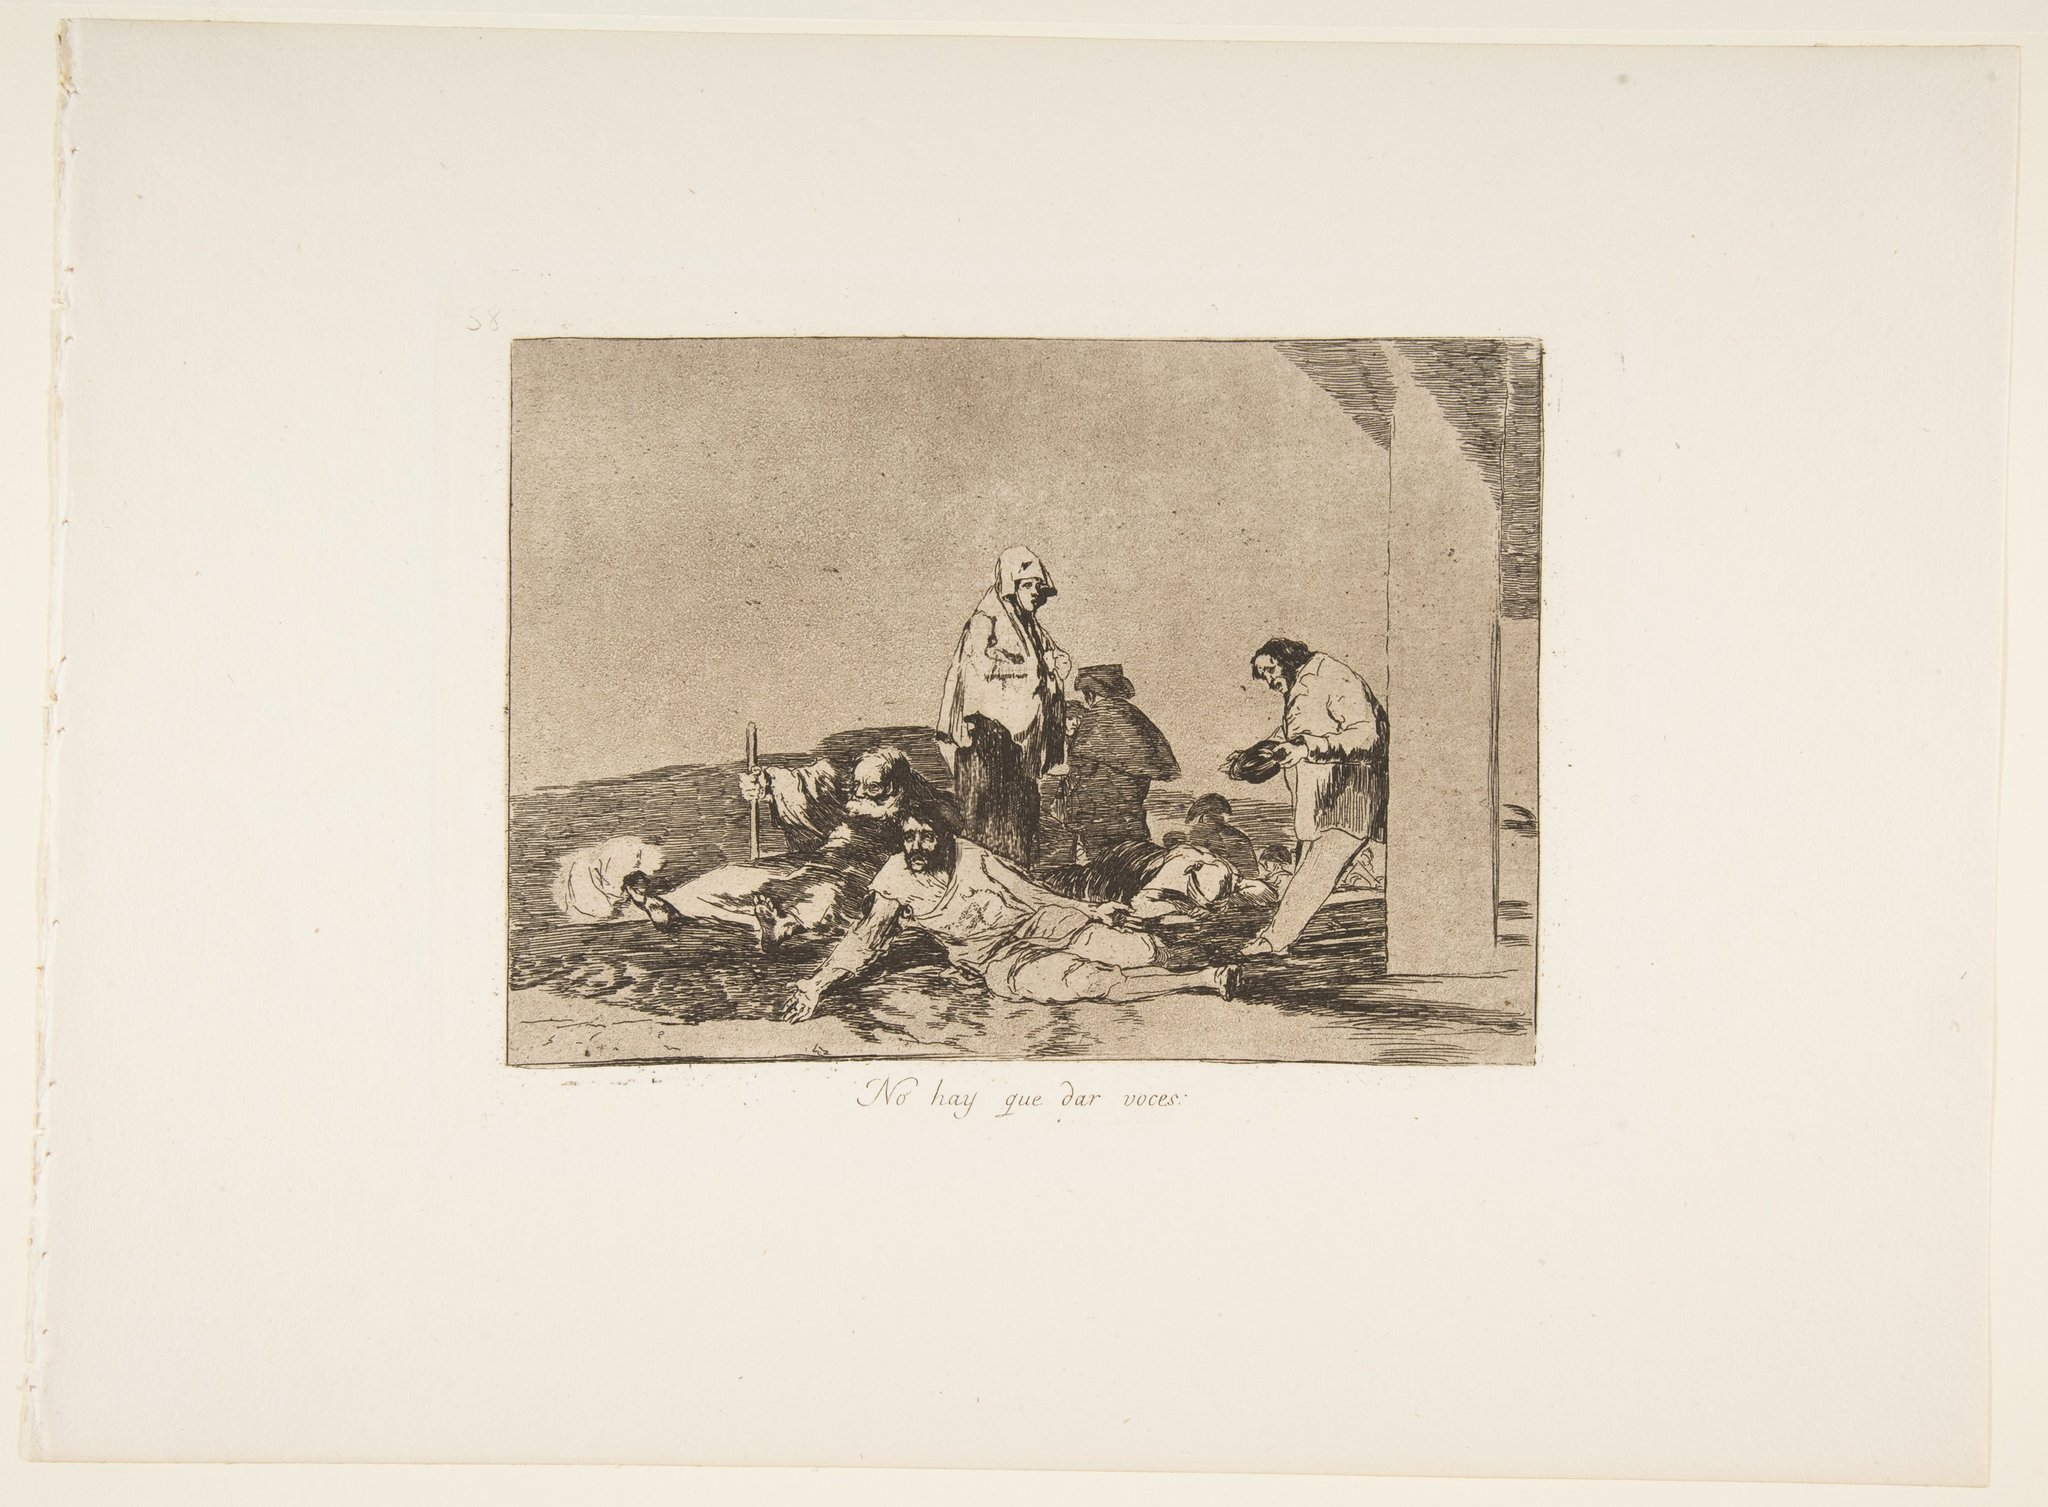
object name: print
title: Plate 58 from "The Disasters of War" (Los Desastres de la Guerra): 'It's no use crying out' (No hay que dar voces)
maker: goya (francisco de goya y lucientes)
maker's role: artist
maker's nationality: spanish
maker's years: 1746-1828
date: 1811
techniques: aquatint, engraving, burnishing, etching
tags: suffering,men,women